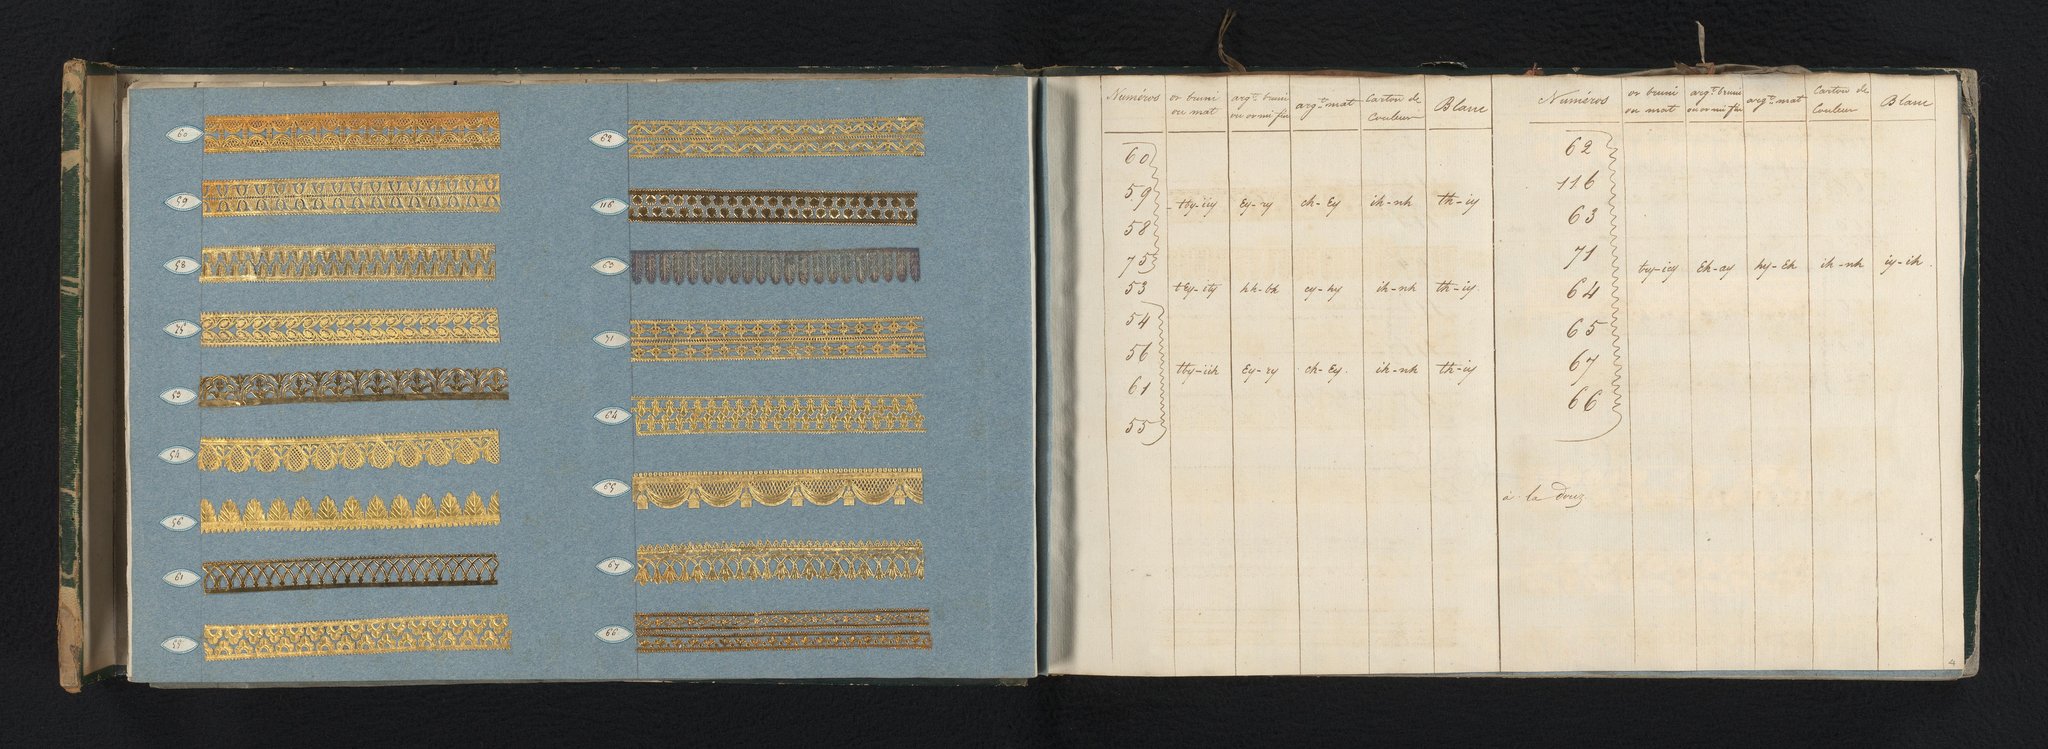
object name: sample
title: Twee bladzijden met stalen van sierlijsten van goudkleurig metaalpapier en bijbehorend tabel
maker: Anonymous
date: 1830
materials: gold leaf, ink, paper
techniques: manufacturing, writing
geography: france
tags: ornaments ~ art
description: Twee bladzijden met links 17 opgeplakte en met etiketten genummerde (60-66) stalen van sierlijsten van goudkleurig metaalpapier. Op de tegenoverliggende rechterbladzijde een tabel met de handgeschreven corresponderende specificaties (in code) per ornament. Onderdeel van het stalenboek geschonken door de dames Van Rijn, vermoedelijk van een Franse papierfabrikant van luxe papieren, of diens vertegenwoordiger in Nederland, ca. 1830.